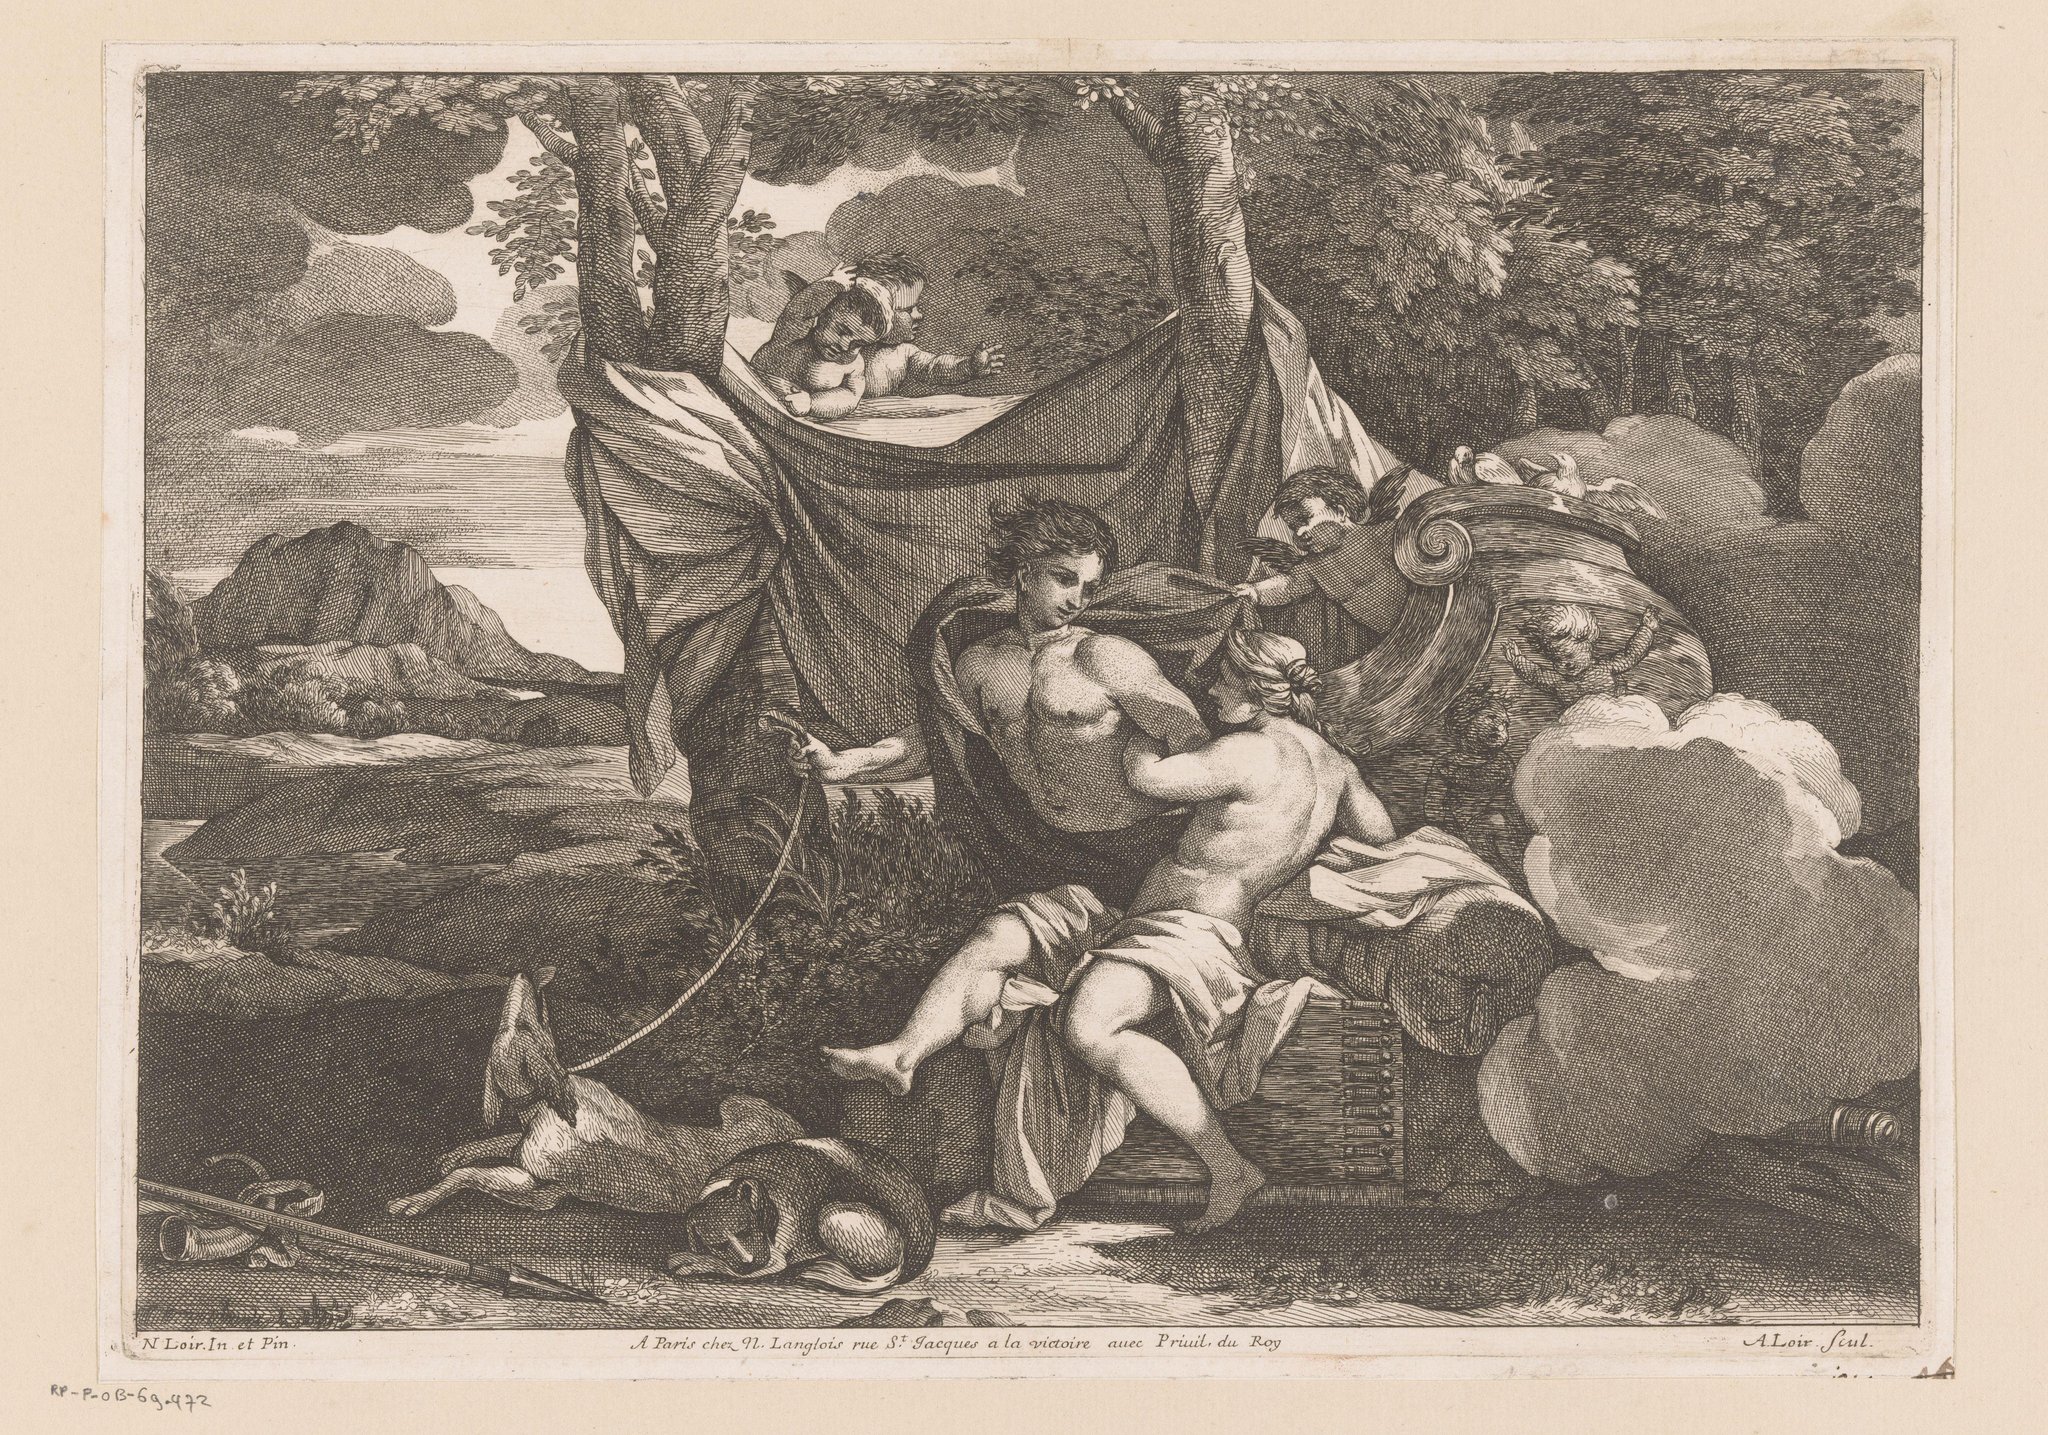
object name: print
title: Venus en Adonis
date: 1650-1703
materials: paper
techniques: etching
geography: paris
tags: venus trying to prevent adonis from going hunting, bed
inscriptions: collector's mark: Lugt 240